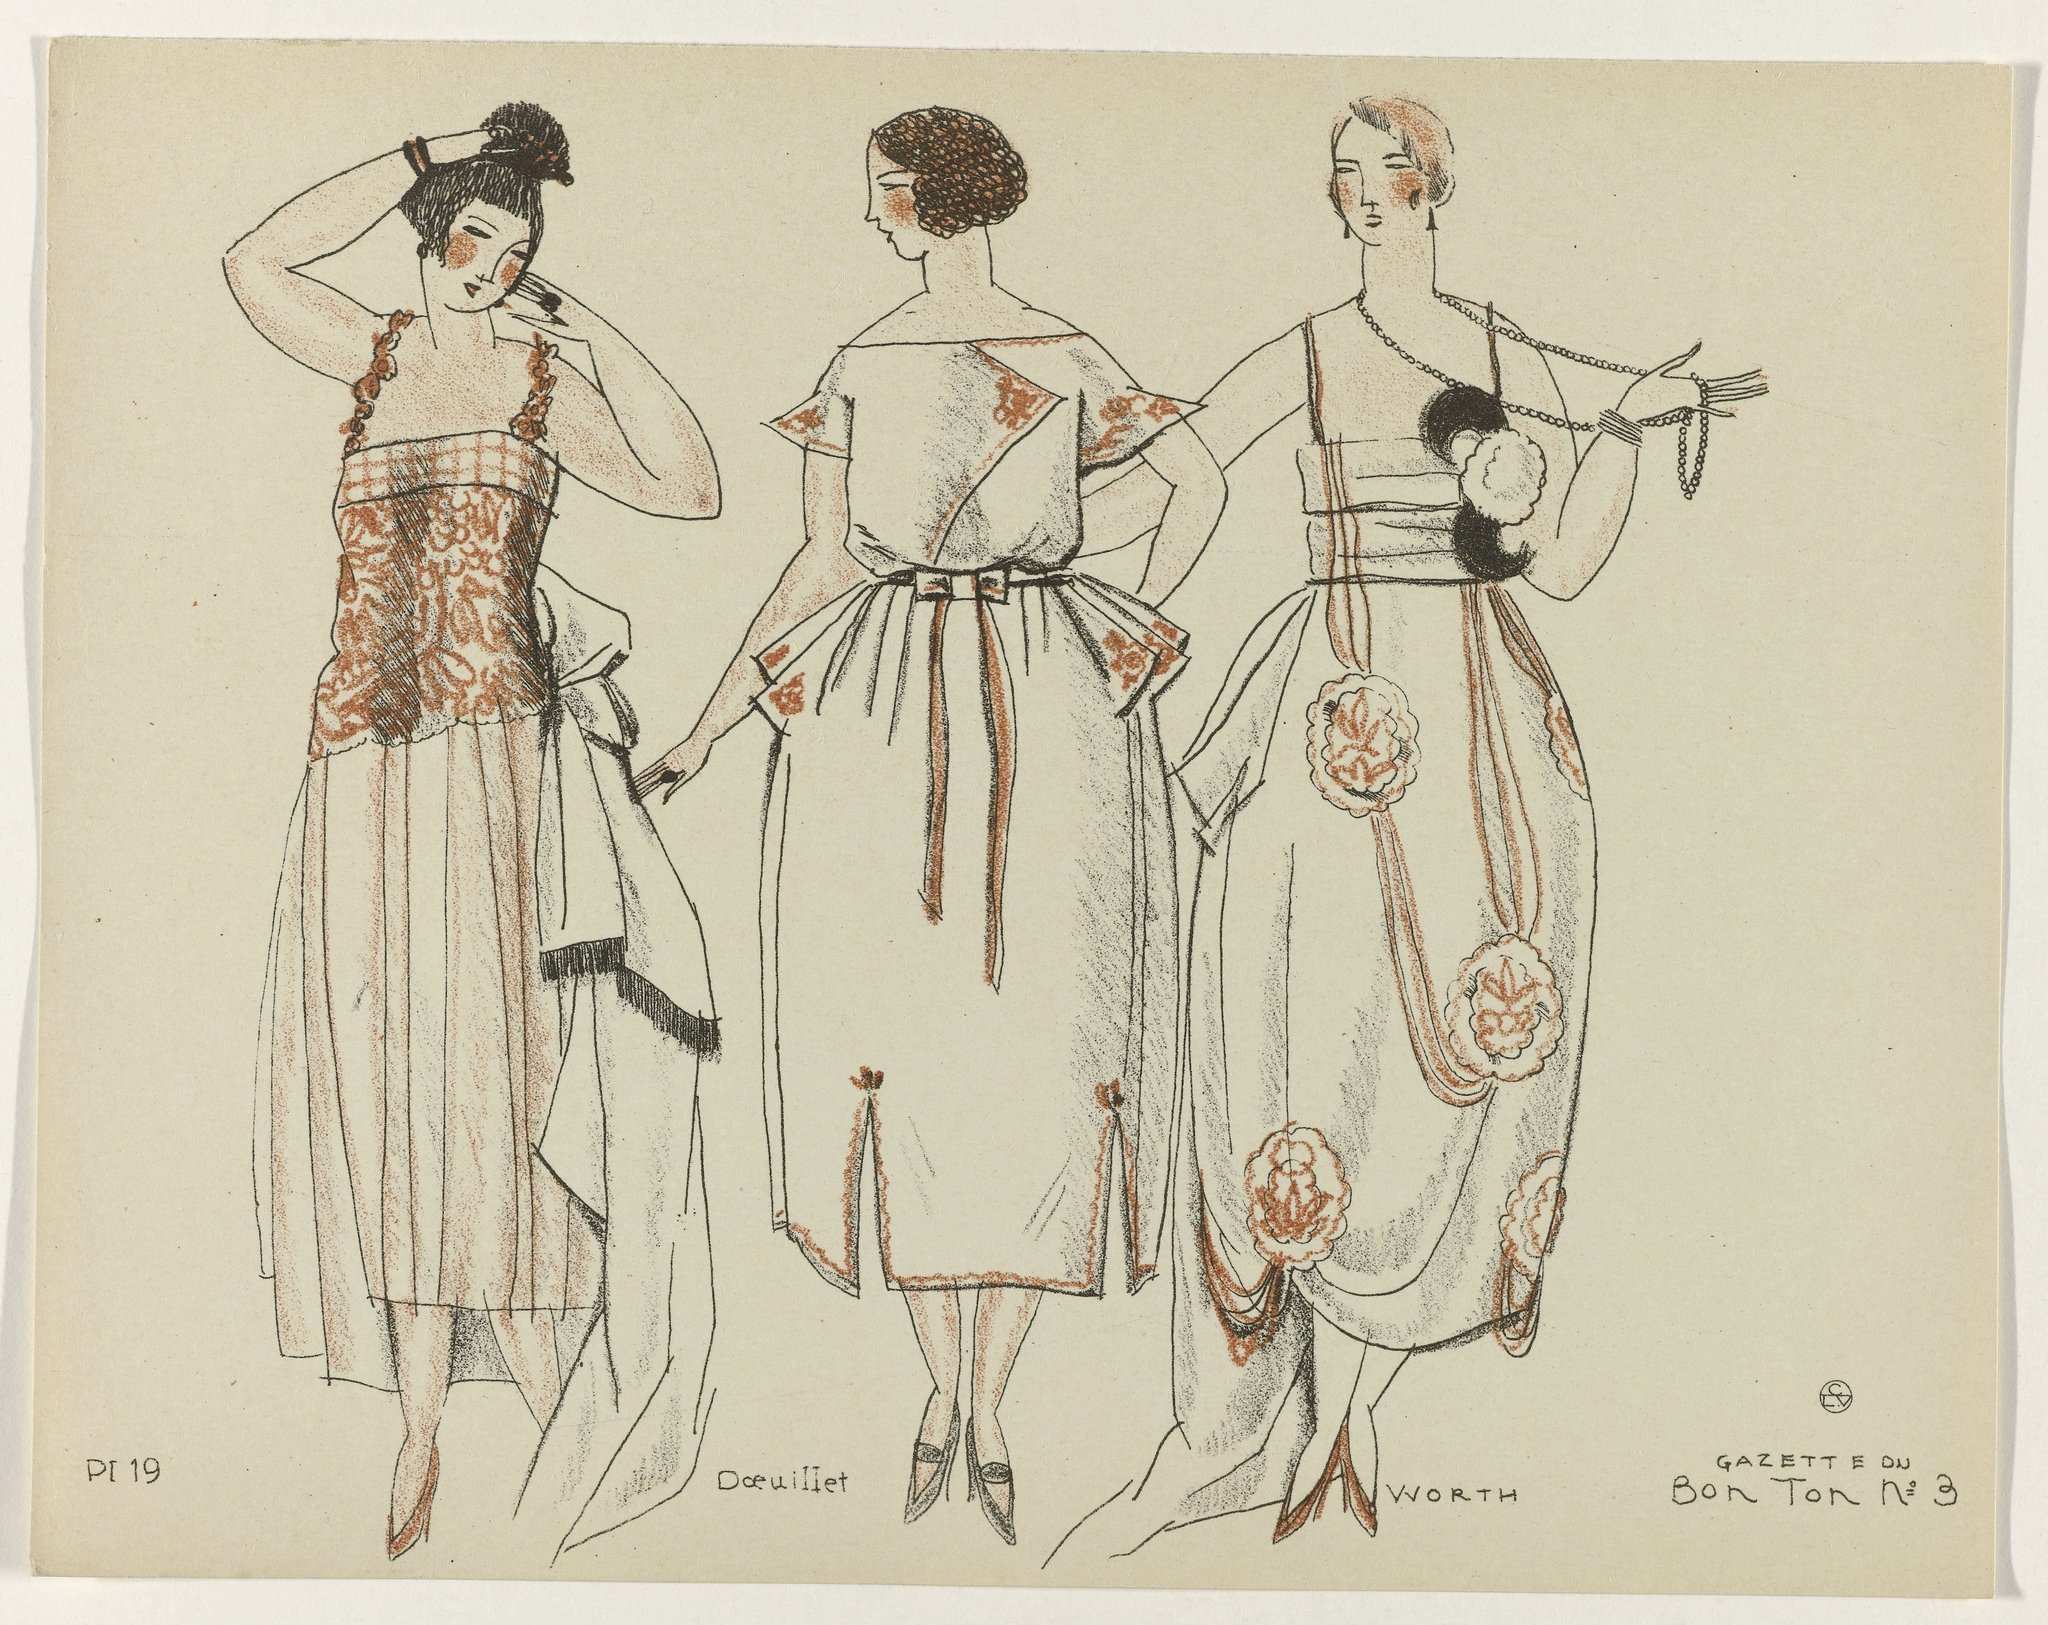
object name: fashion print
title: Gazette du Bon Ton, 1920 - No. 3, Croquis Pl. 19: Doeuillet / Worth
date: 1920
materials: paper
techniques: lithograph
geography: paris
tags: dress, gown: evening dress (+ women's clothes), dress, gown: dinner dress (+ women's clothes), fashion plates, bracelet, wristlet (+ women's clothes), necklace (+ women's clothes)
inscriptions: date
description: Avondjapon en een geborduurde dinerjapon van Doeuillet en een satijnen avondjapon van Worth, met een geplooid lijfje versierd met een roos en aigrette. Croquis Pl. 19 uit Gazette du Bon Ton 1920, No. 3. Uitleg over de kleding op pagina "Explication des Planches".